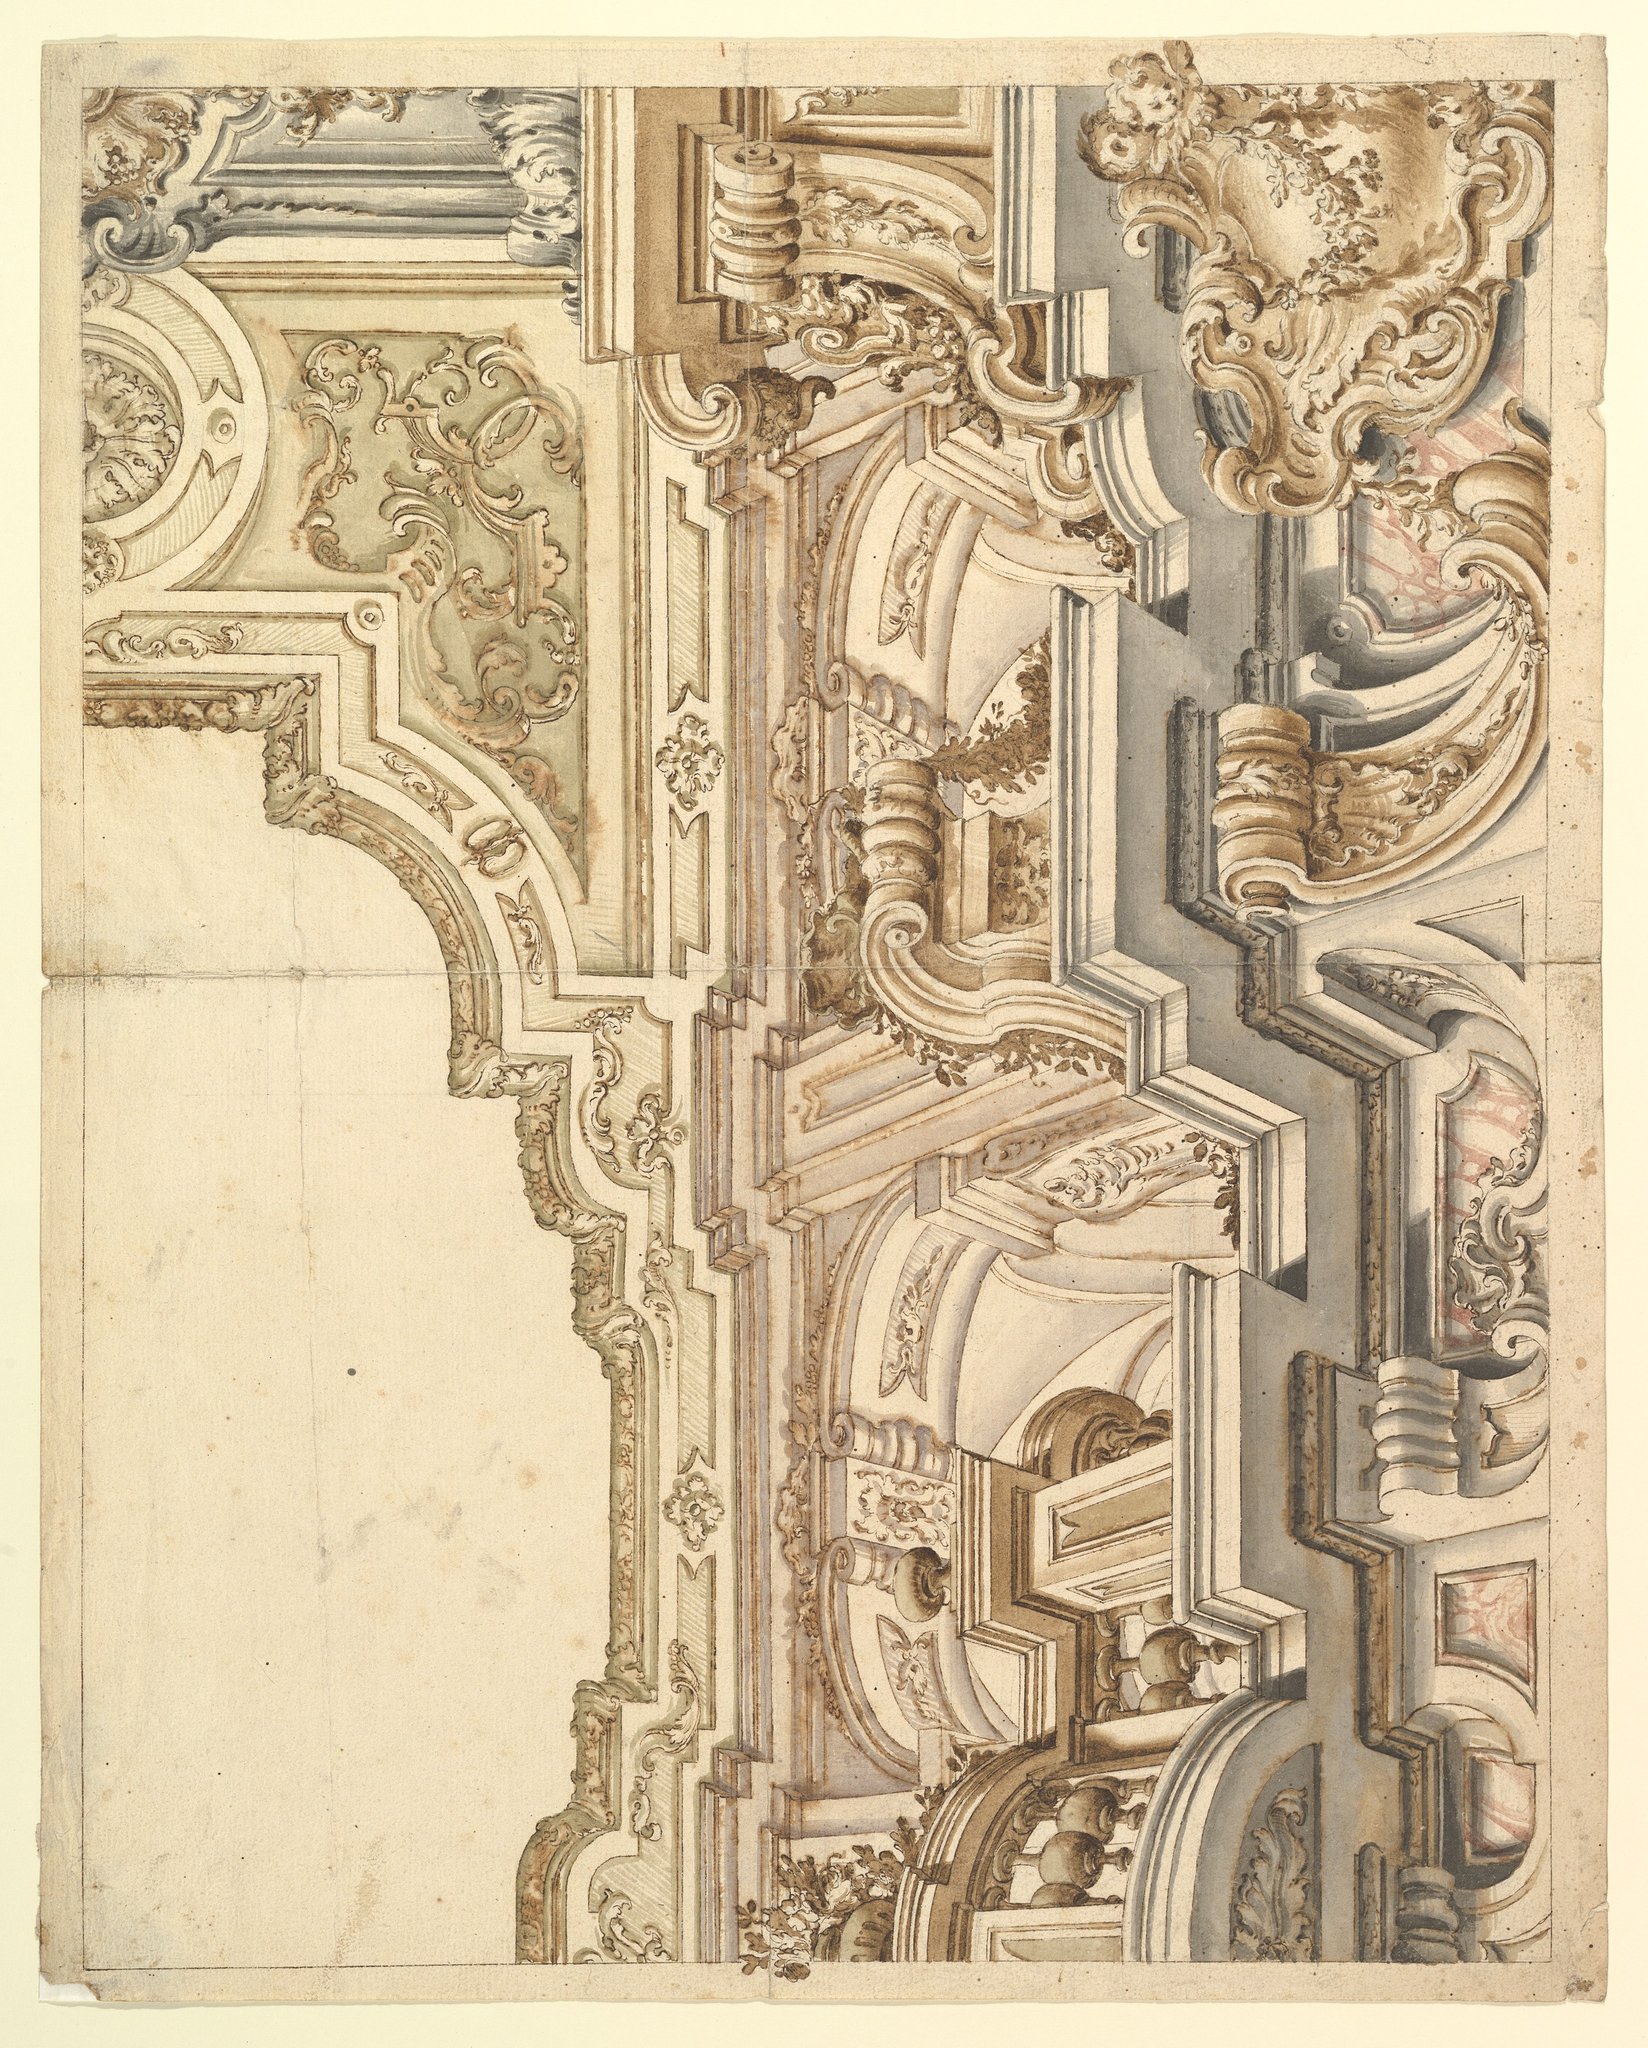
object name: drawing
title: Design for a Cornice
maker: anonymous, italian, piedmontese, 18th century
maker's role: artist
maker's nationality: italian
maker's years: 1700-1800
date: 1700-1780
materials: graphite, ink, drawing material, watercolor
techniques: pen